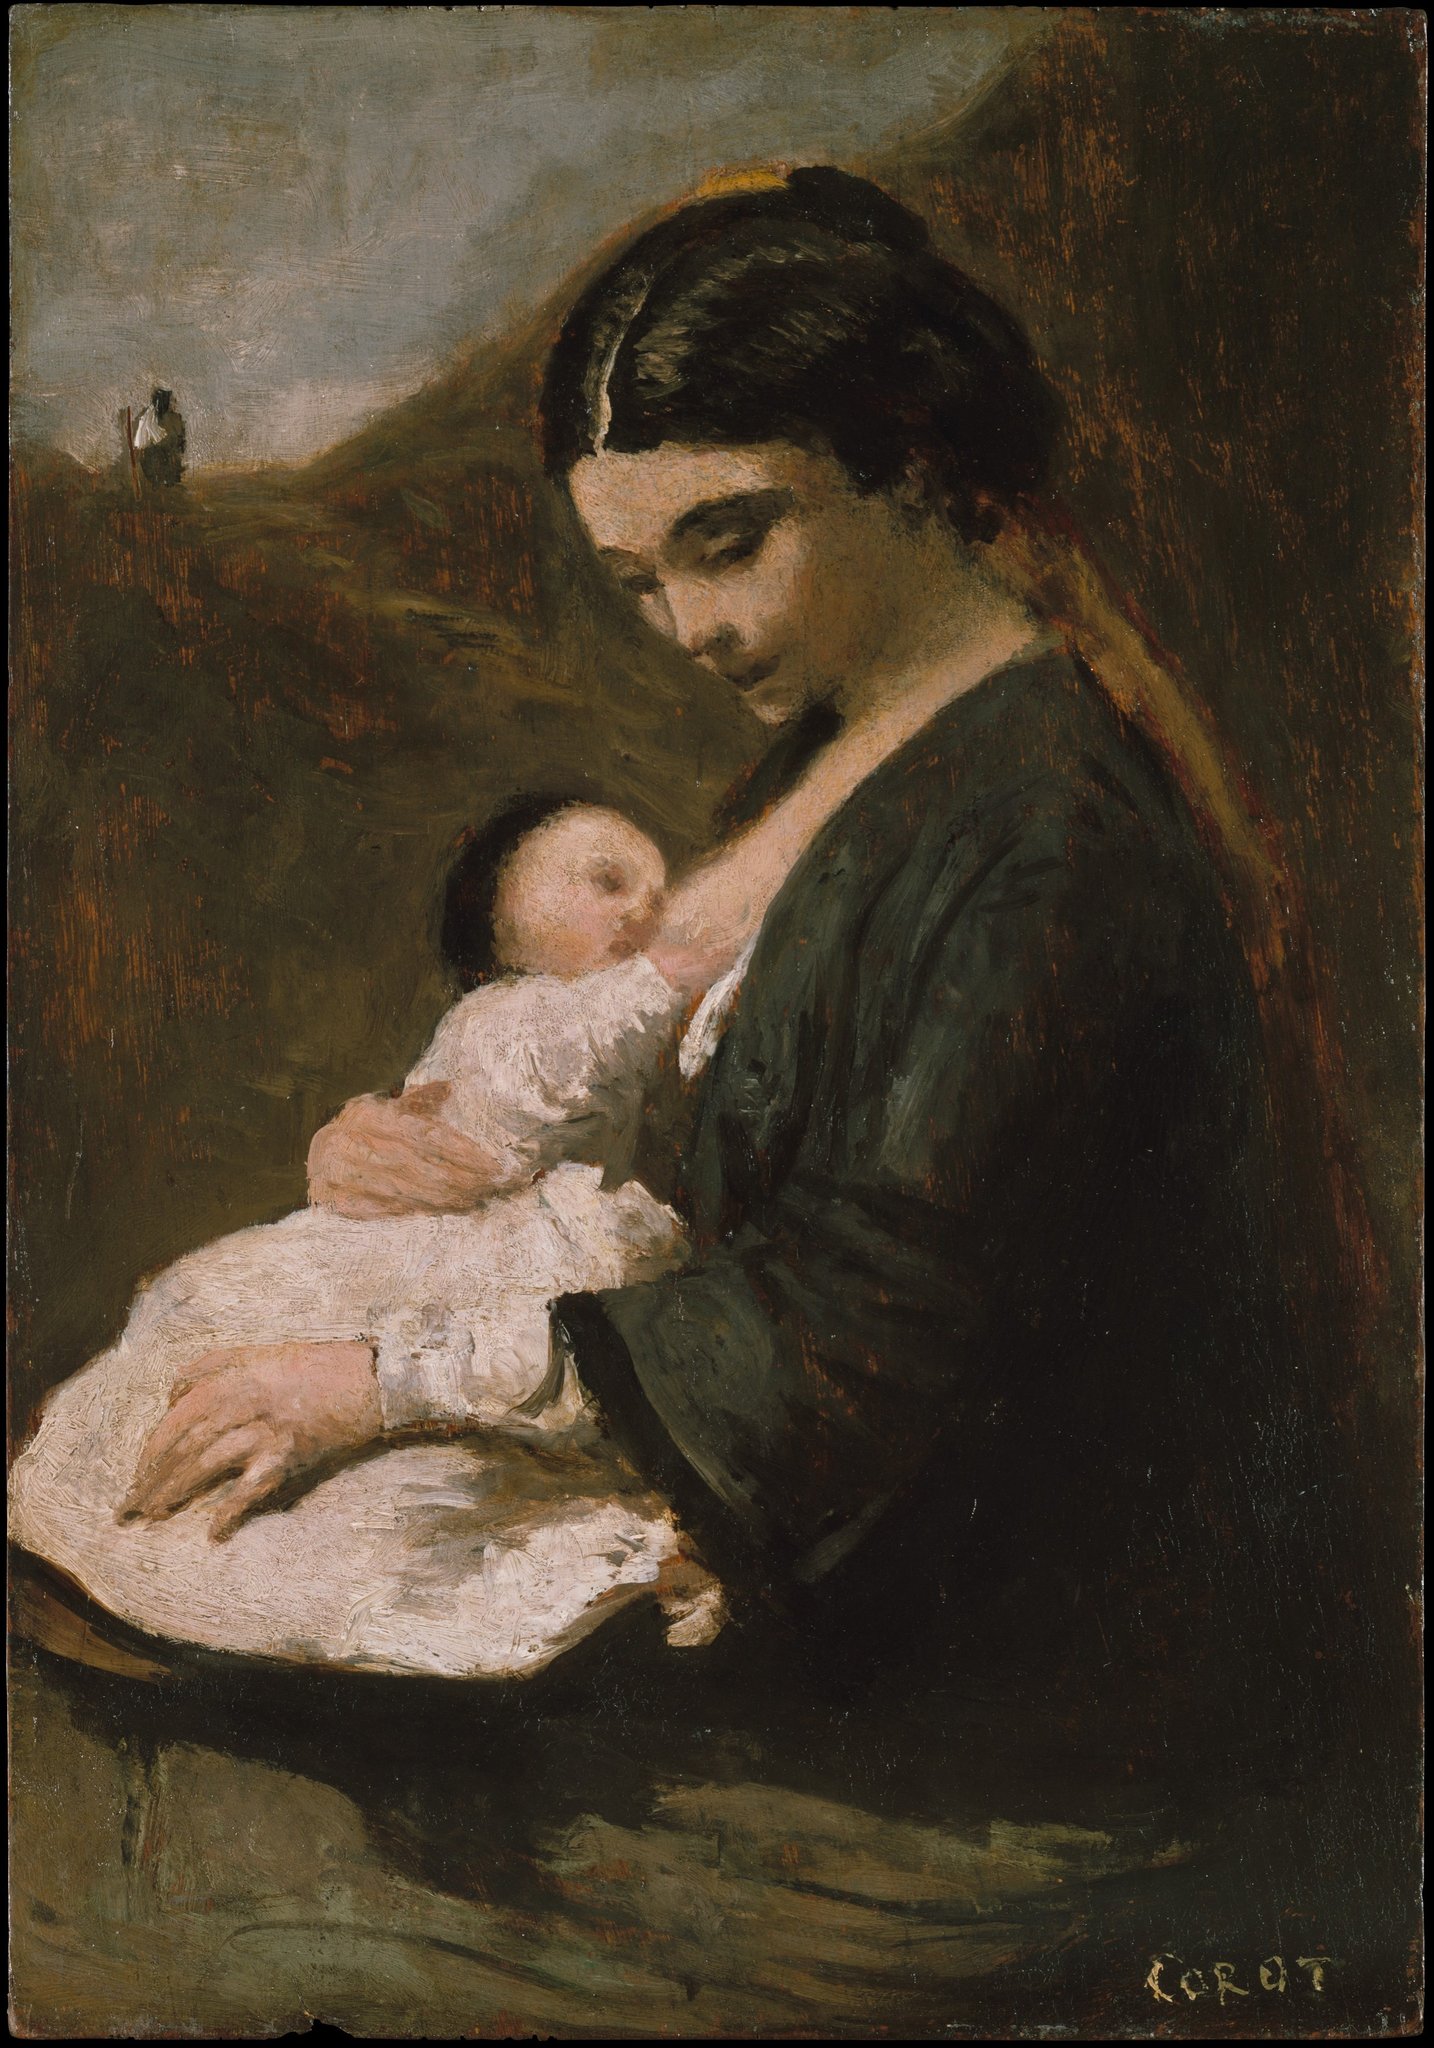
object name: painting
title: Mother and Child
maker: jean-baptiste-camille corot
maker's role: artist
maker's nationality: french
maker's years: 1796-1875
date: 1860-1869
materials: oil, wood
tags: infants,mothers,women,nursing